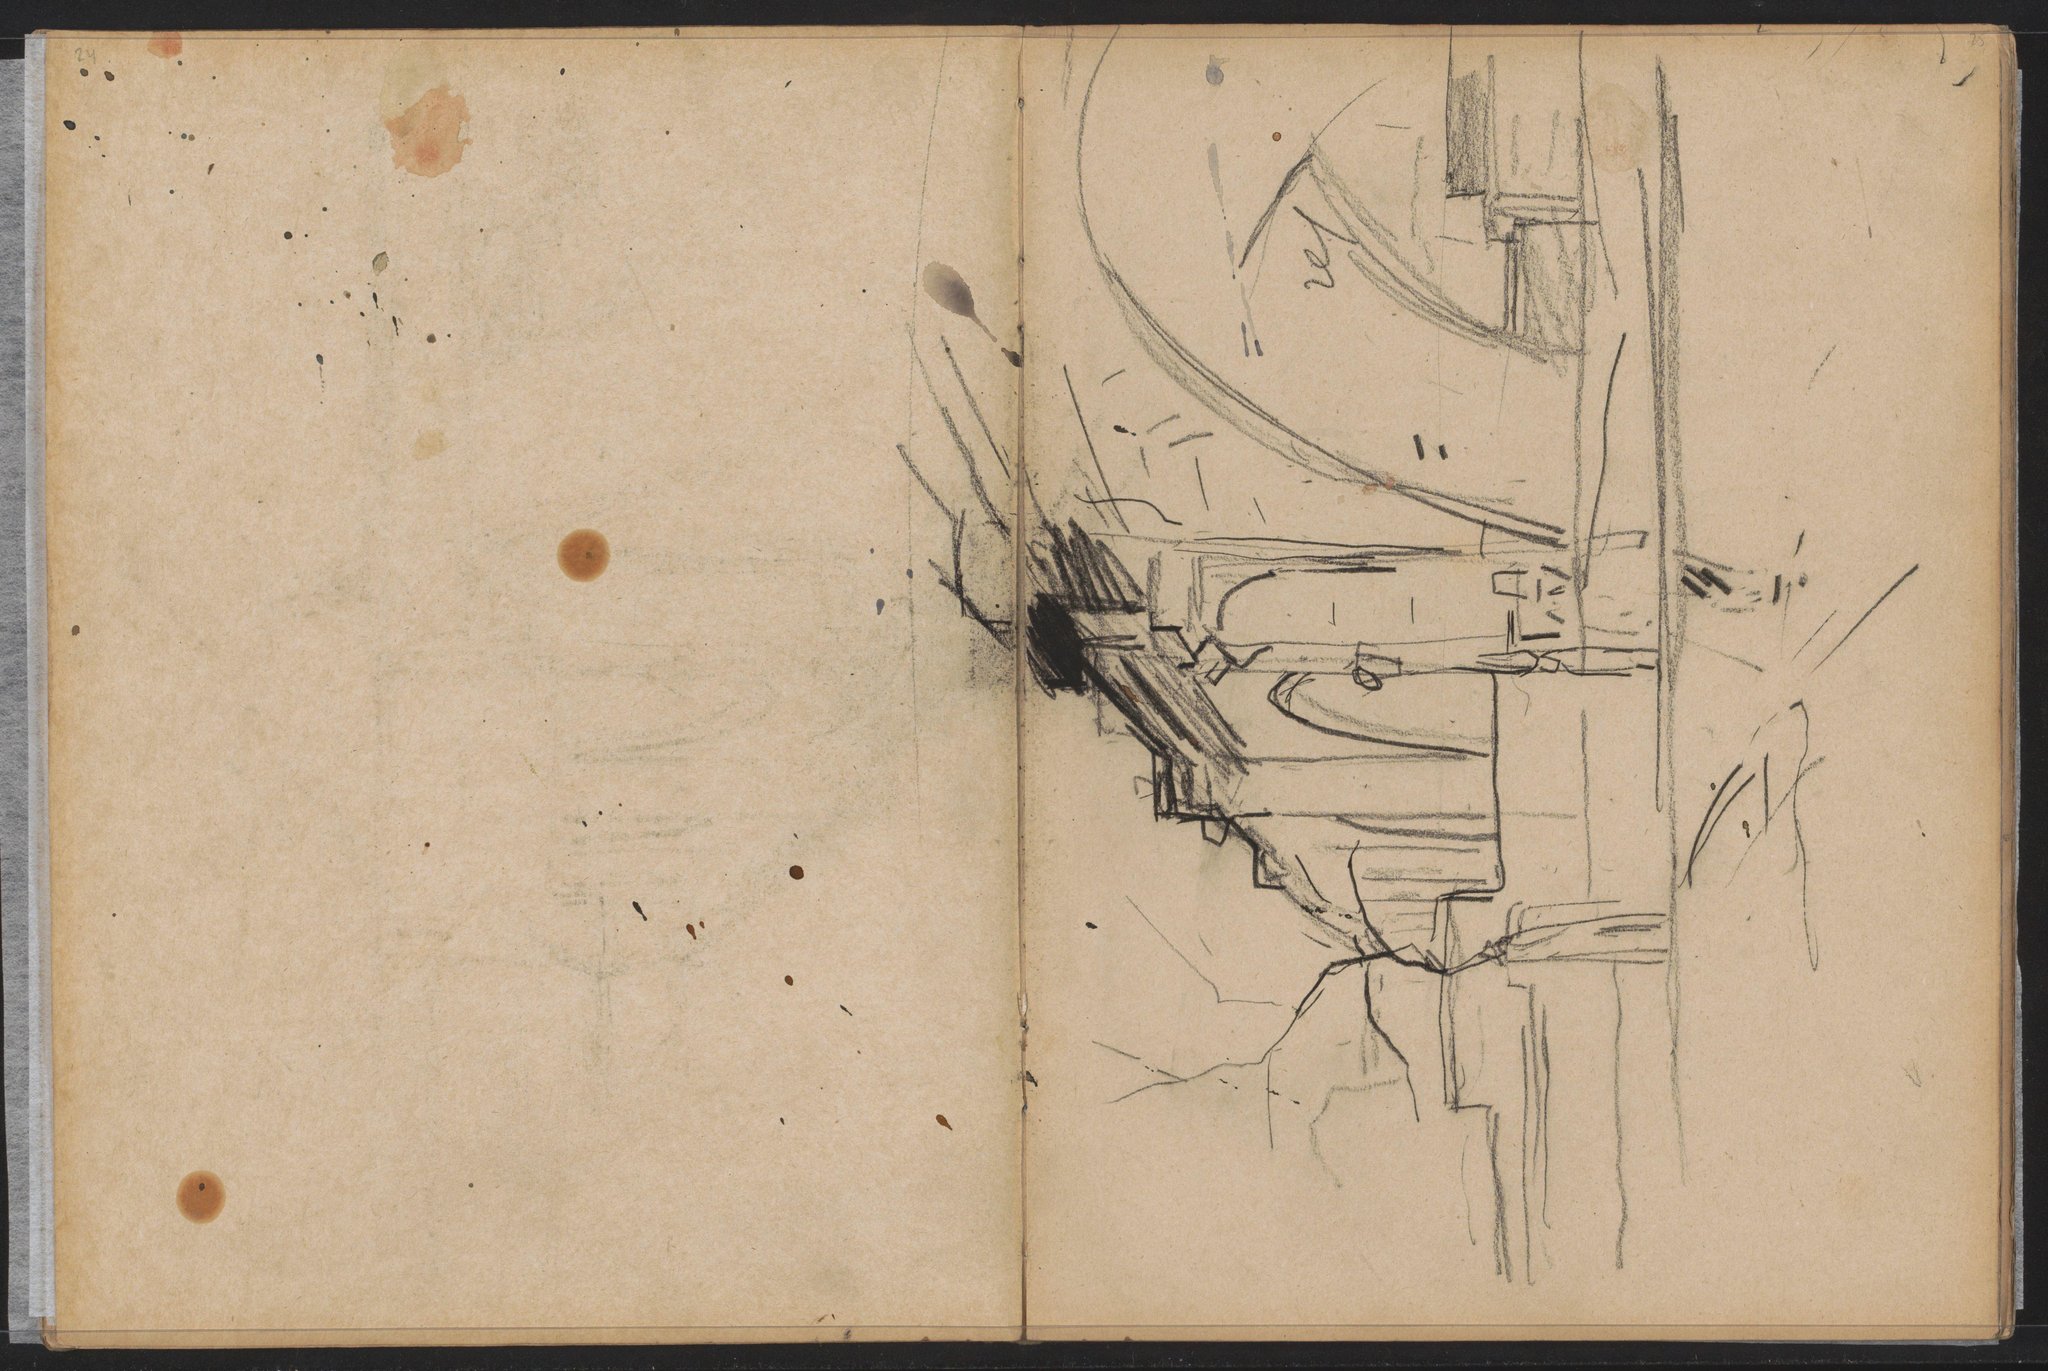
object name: sketchbook leaf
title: Gezicht op Waterloo Bridge te Londen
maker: willem witsen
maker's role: draughtsman, painter, print maker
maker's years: 1860-1923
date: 1888-1891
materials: chalk, paper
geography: london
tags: river, bridge in city across river, canal, etc., thames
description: Pagina 24 en pagina 25 uit een schetsboek met 40 bladen.